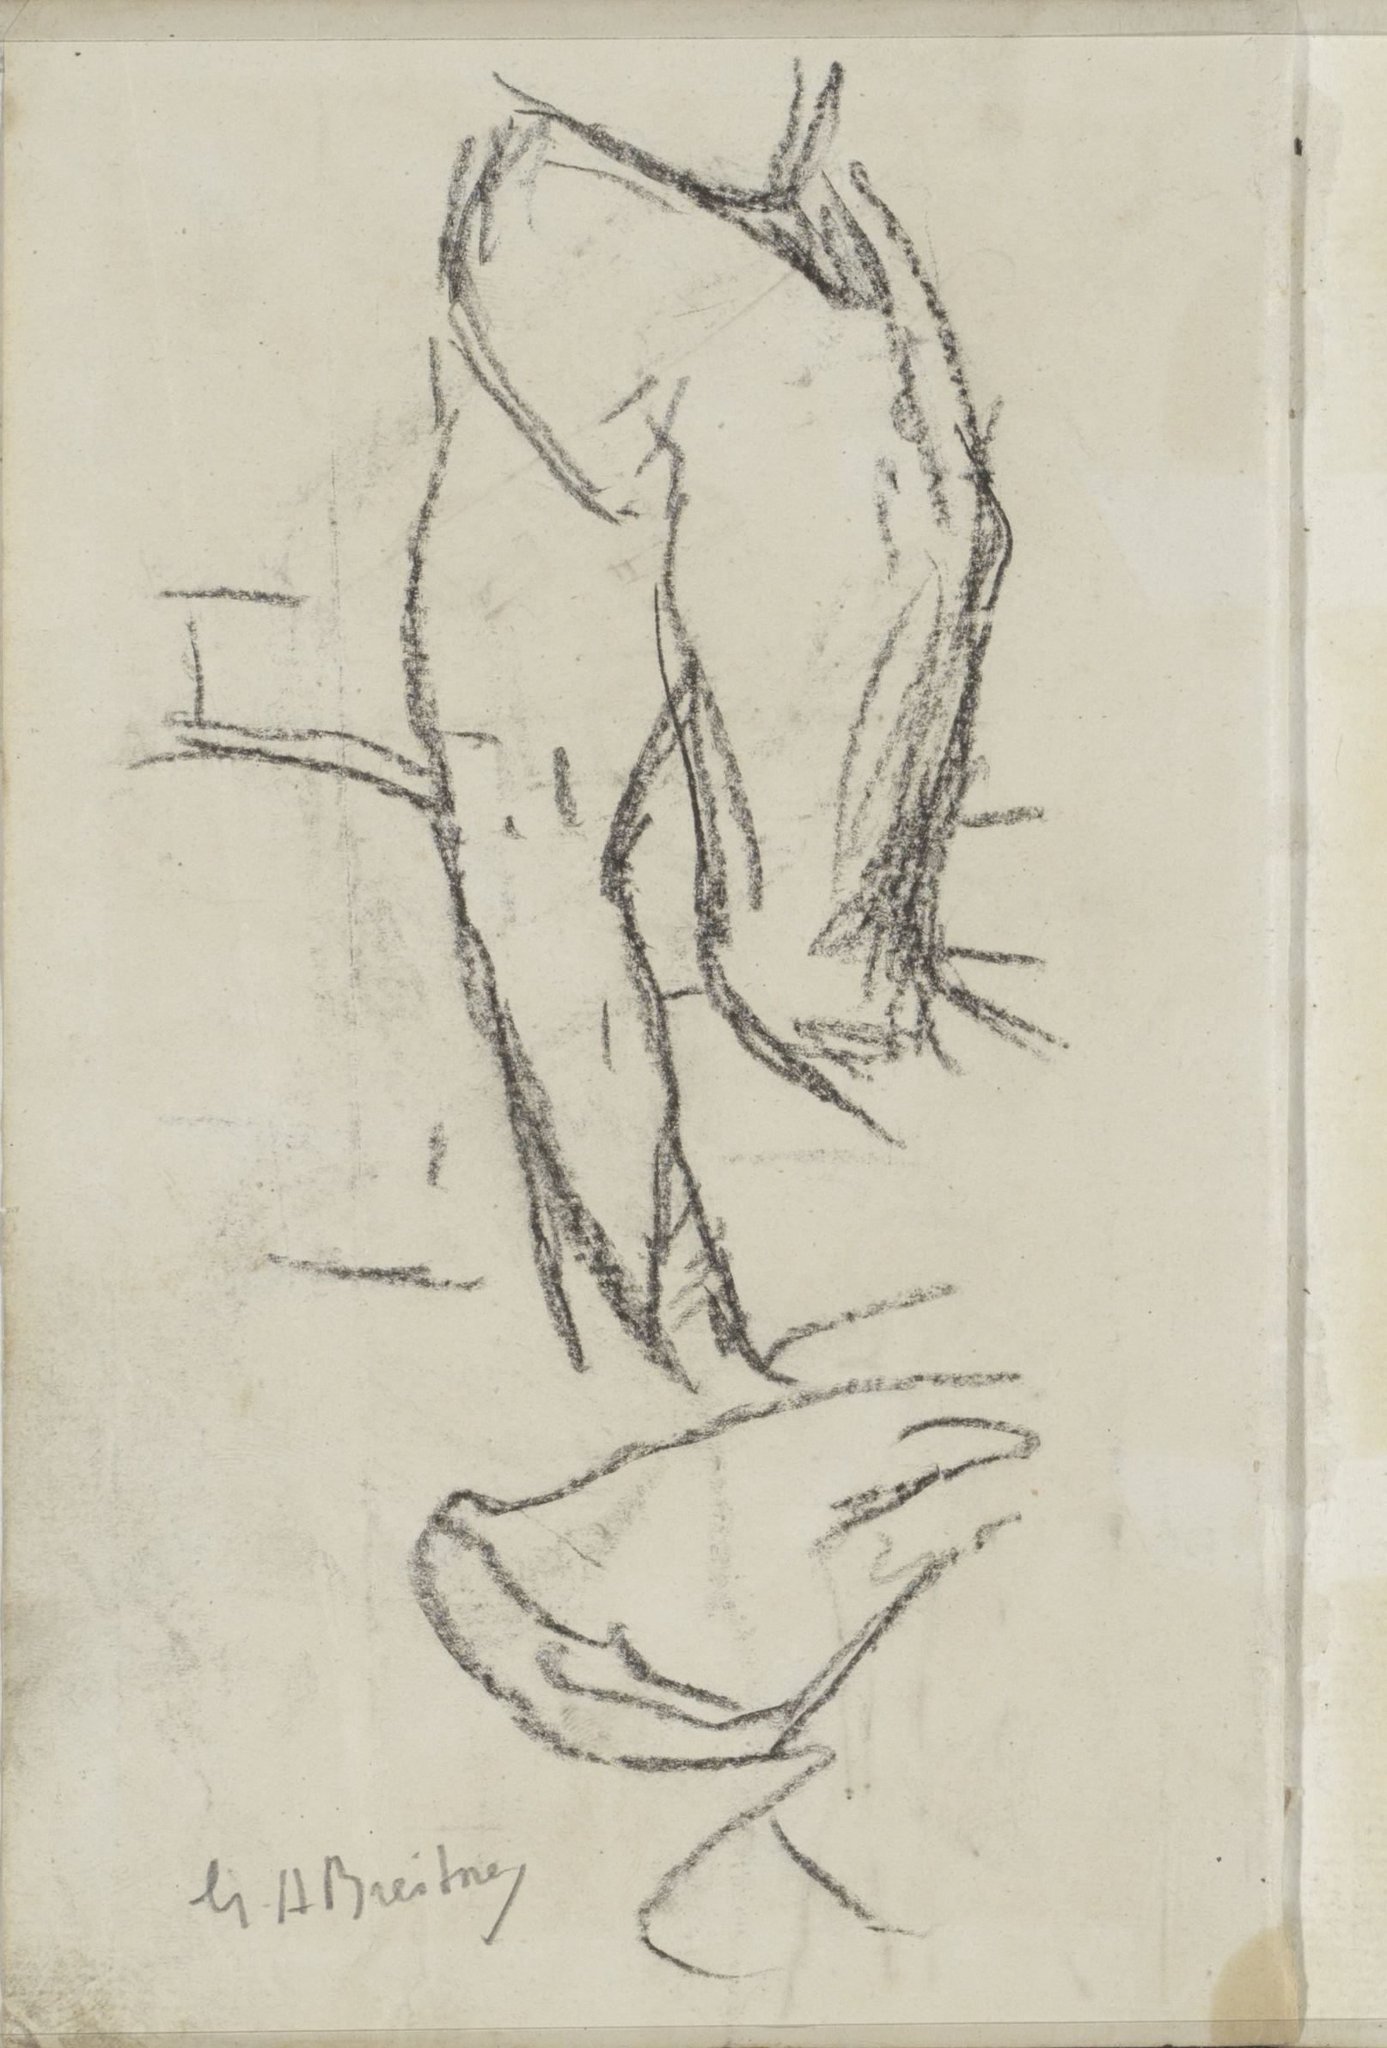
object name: sketchbook leaf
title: Standing Female Nude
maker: george hendrik breitner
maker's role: draughtsman, painter, print maker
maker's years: 1857-1923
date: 1892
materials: chalk, paper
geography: amsterdam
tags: standing figure - aa - female human figure (+ nude human being)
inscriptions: signature: ‘G.H. Breitner’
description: Pagina 3 uit een schetsboek met 20 bladen.